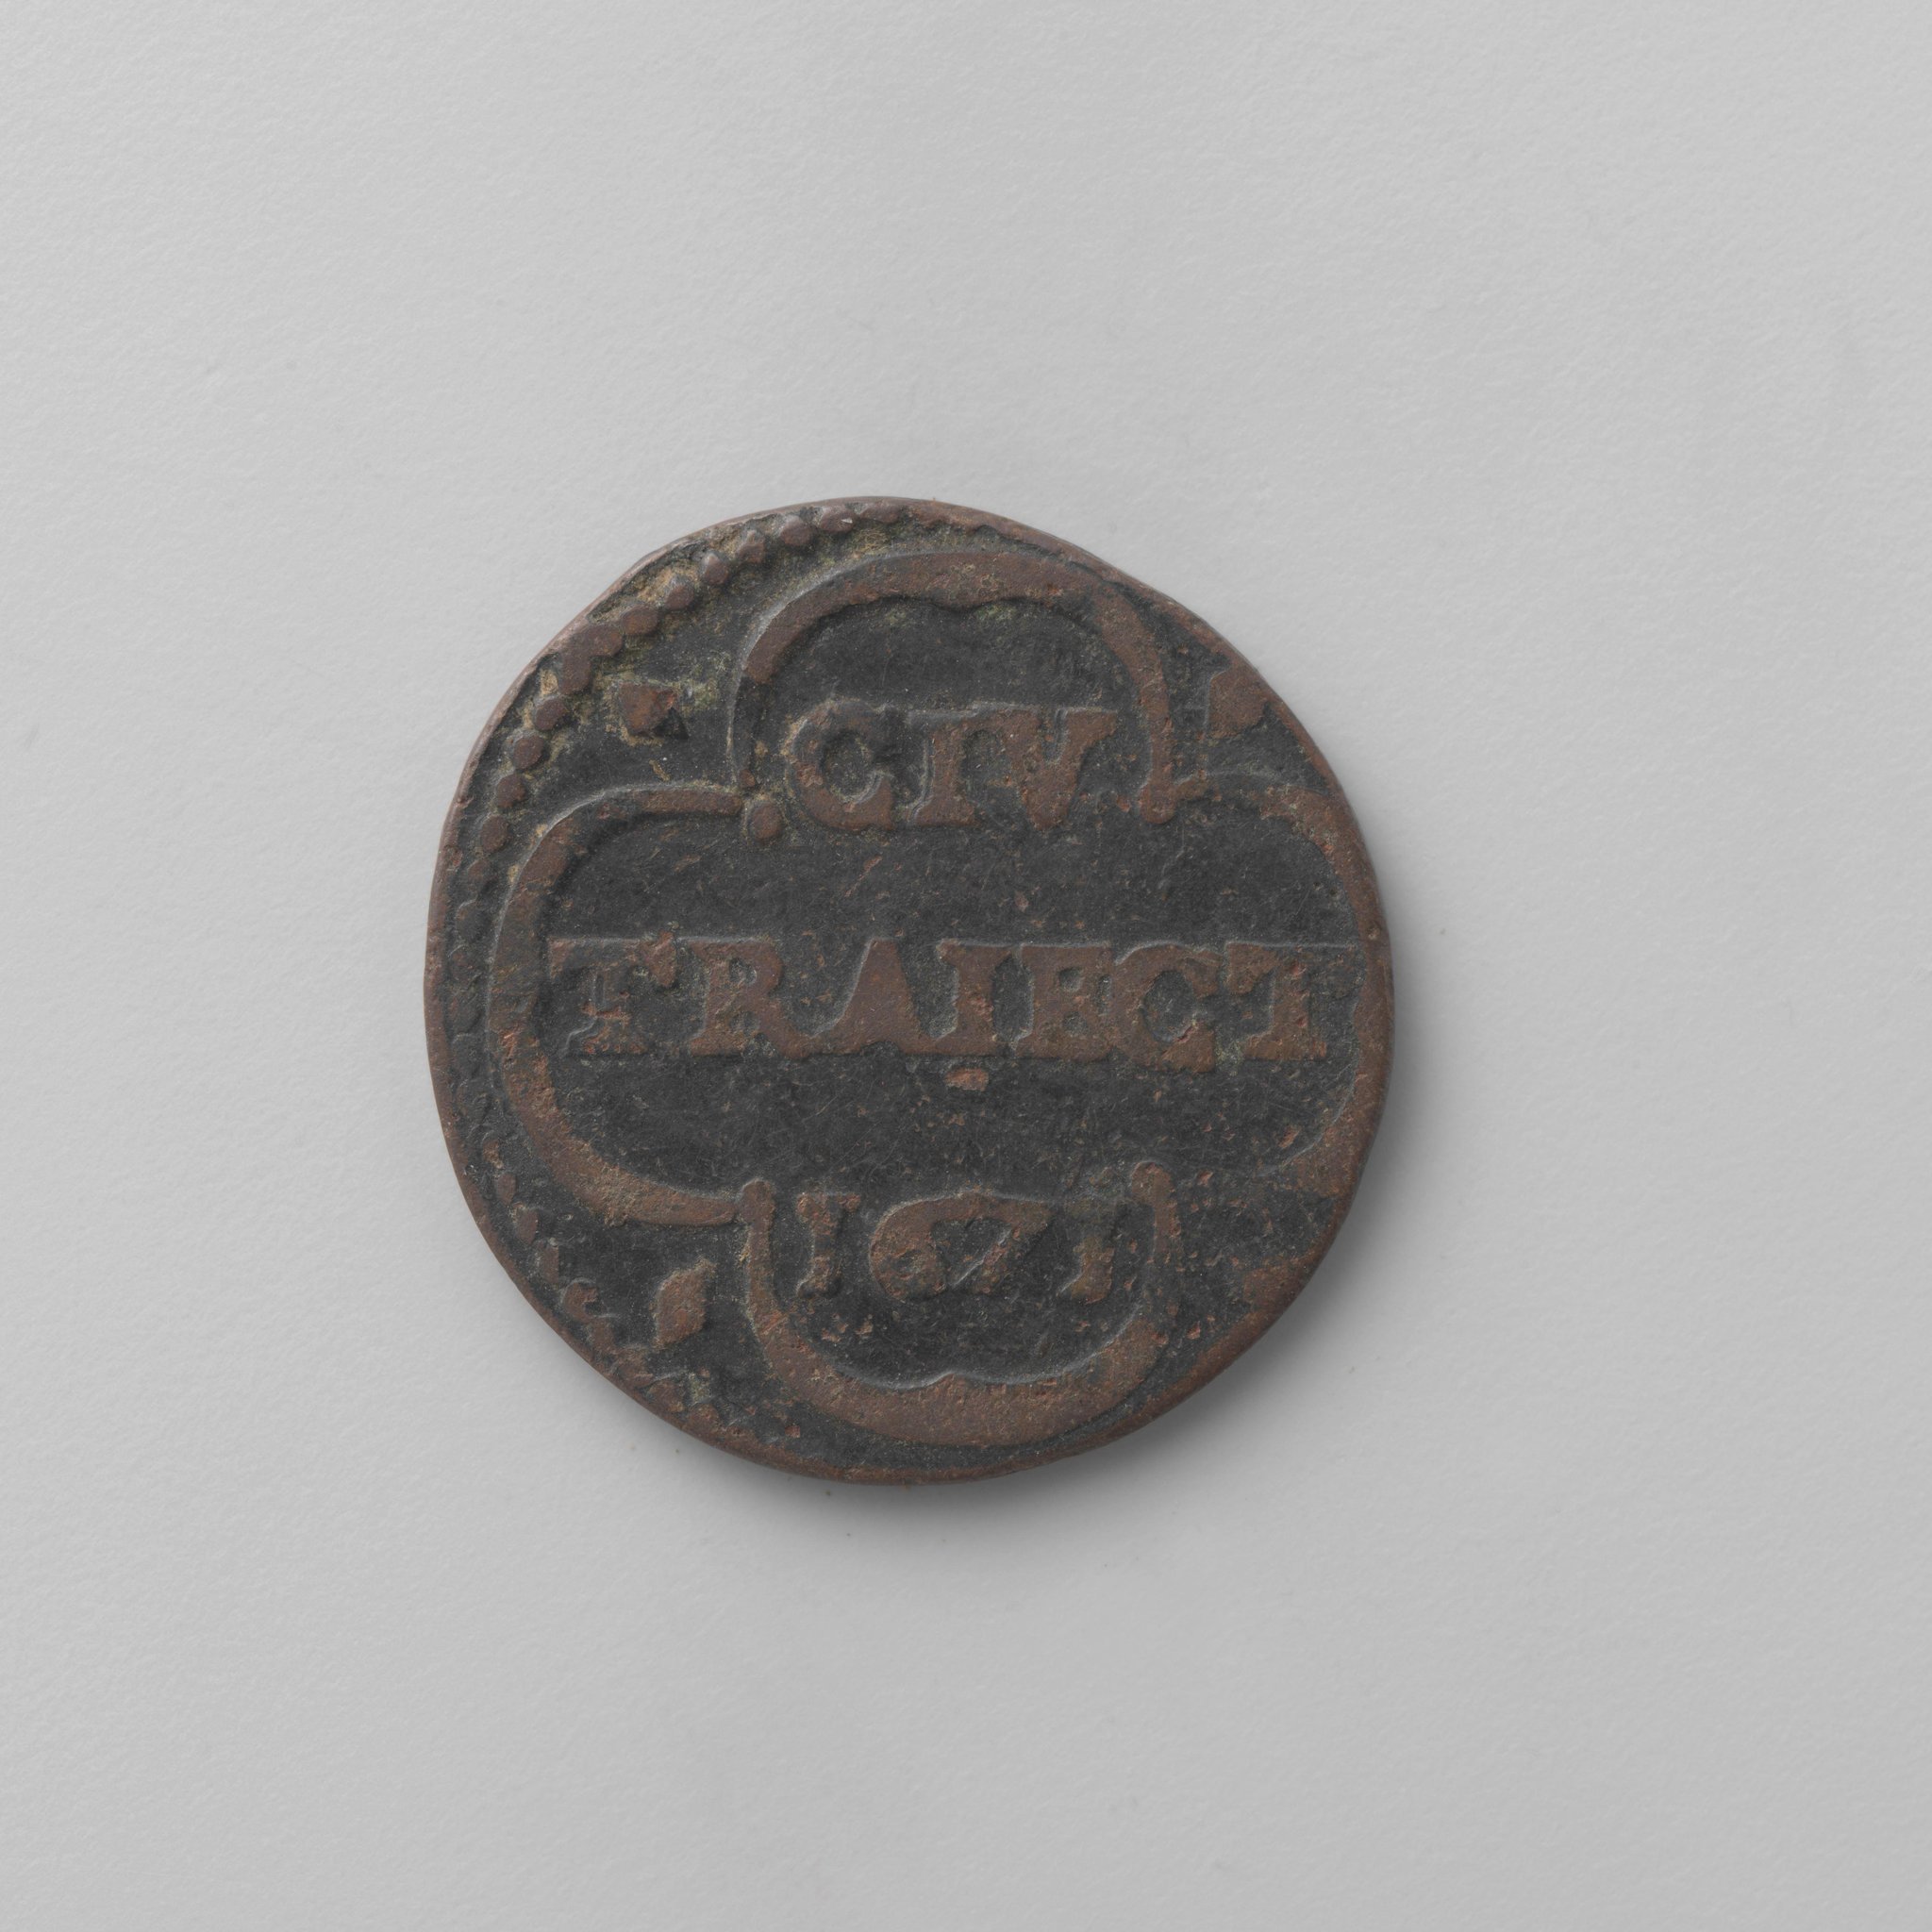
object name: coin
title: Duit van de stad Utrecht, 1671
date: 1671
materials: copper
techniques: striking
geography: utrecht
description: Koperen munt. Voorzijde: gekroond stedelijk, horizontaal gearceeerd wapenschild, gehouden door twee leeuwen. Keerzijde: binnen een versierde vierpas opschrift in twee regels, waaronder jaartal.